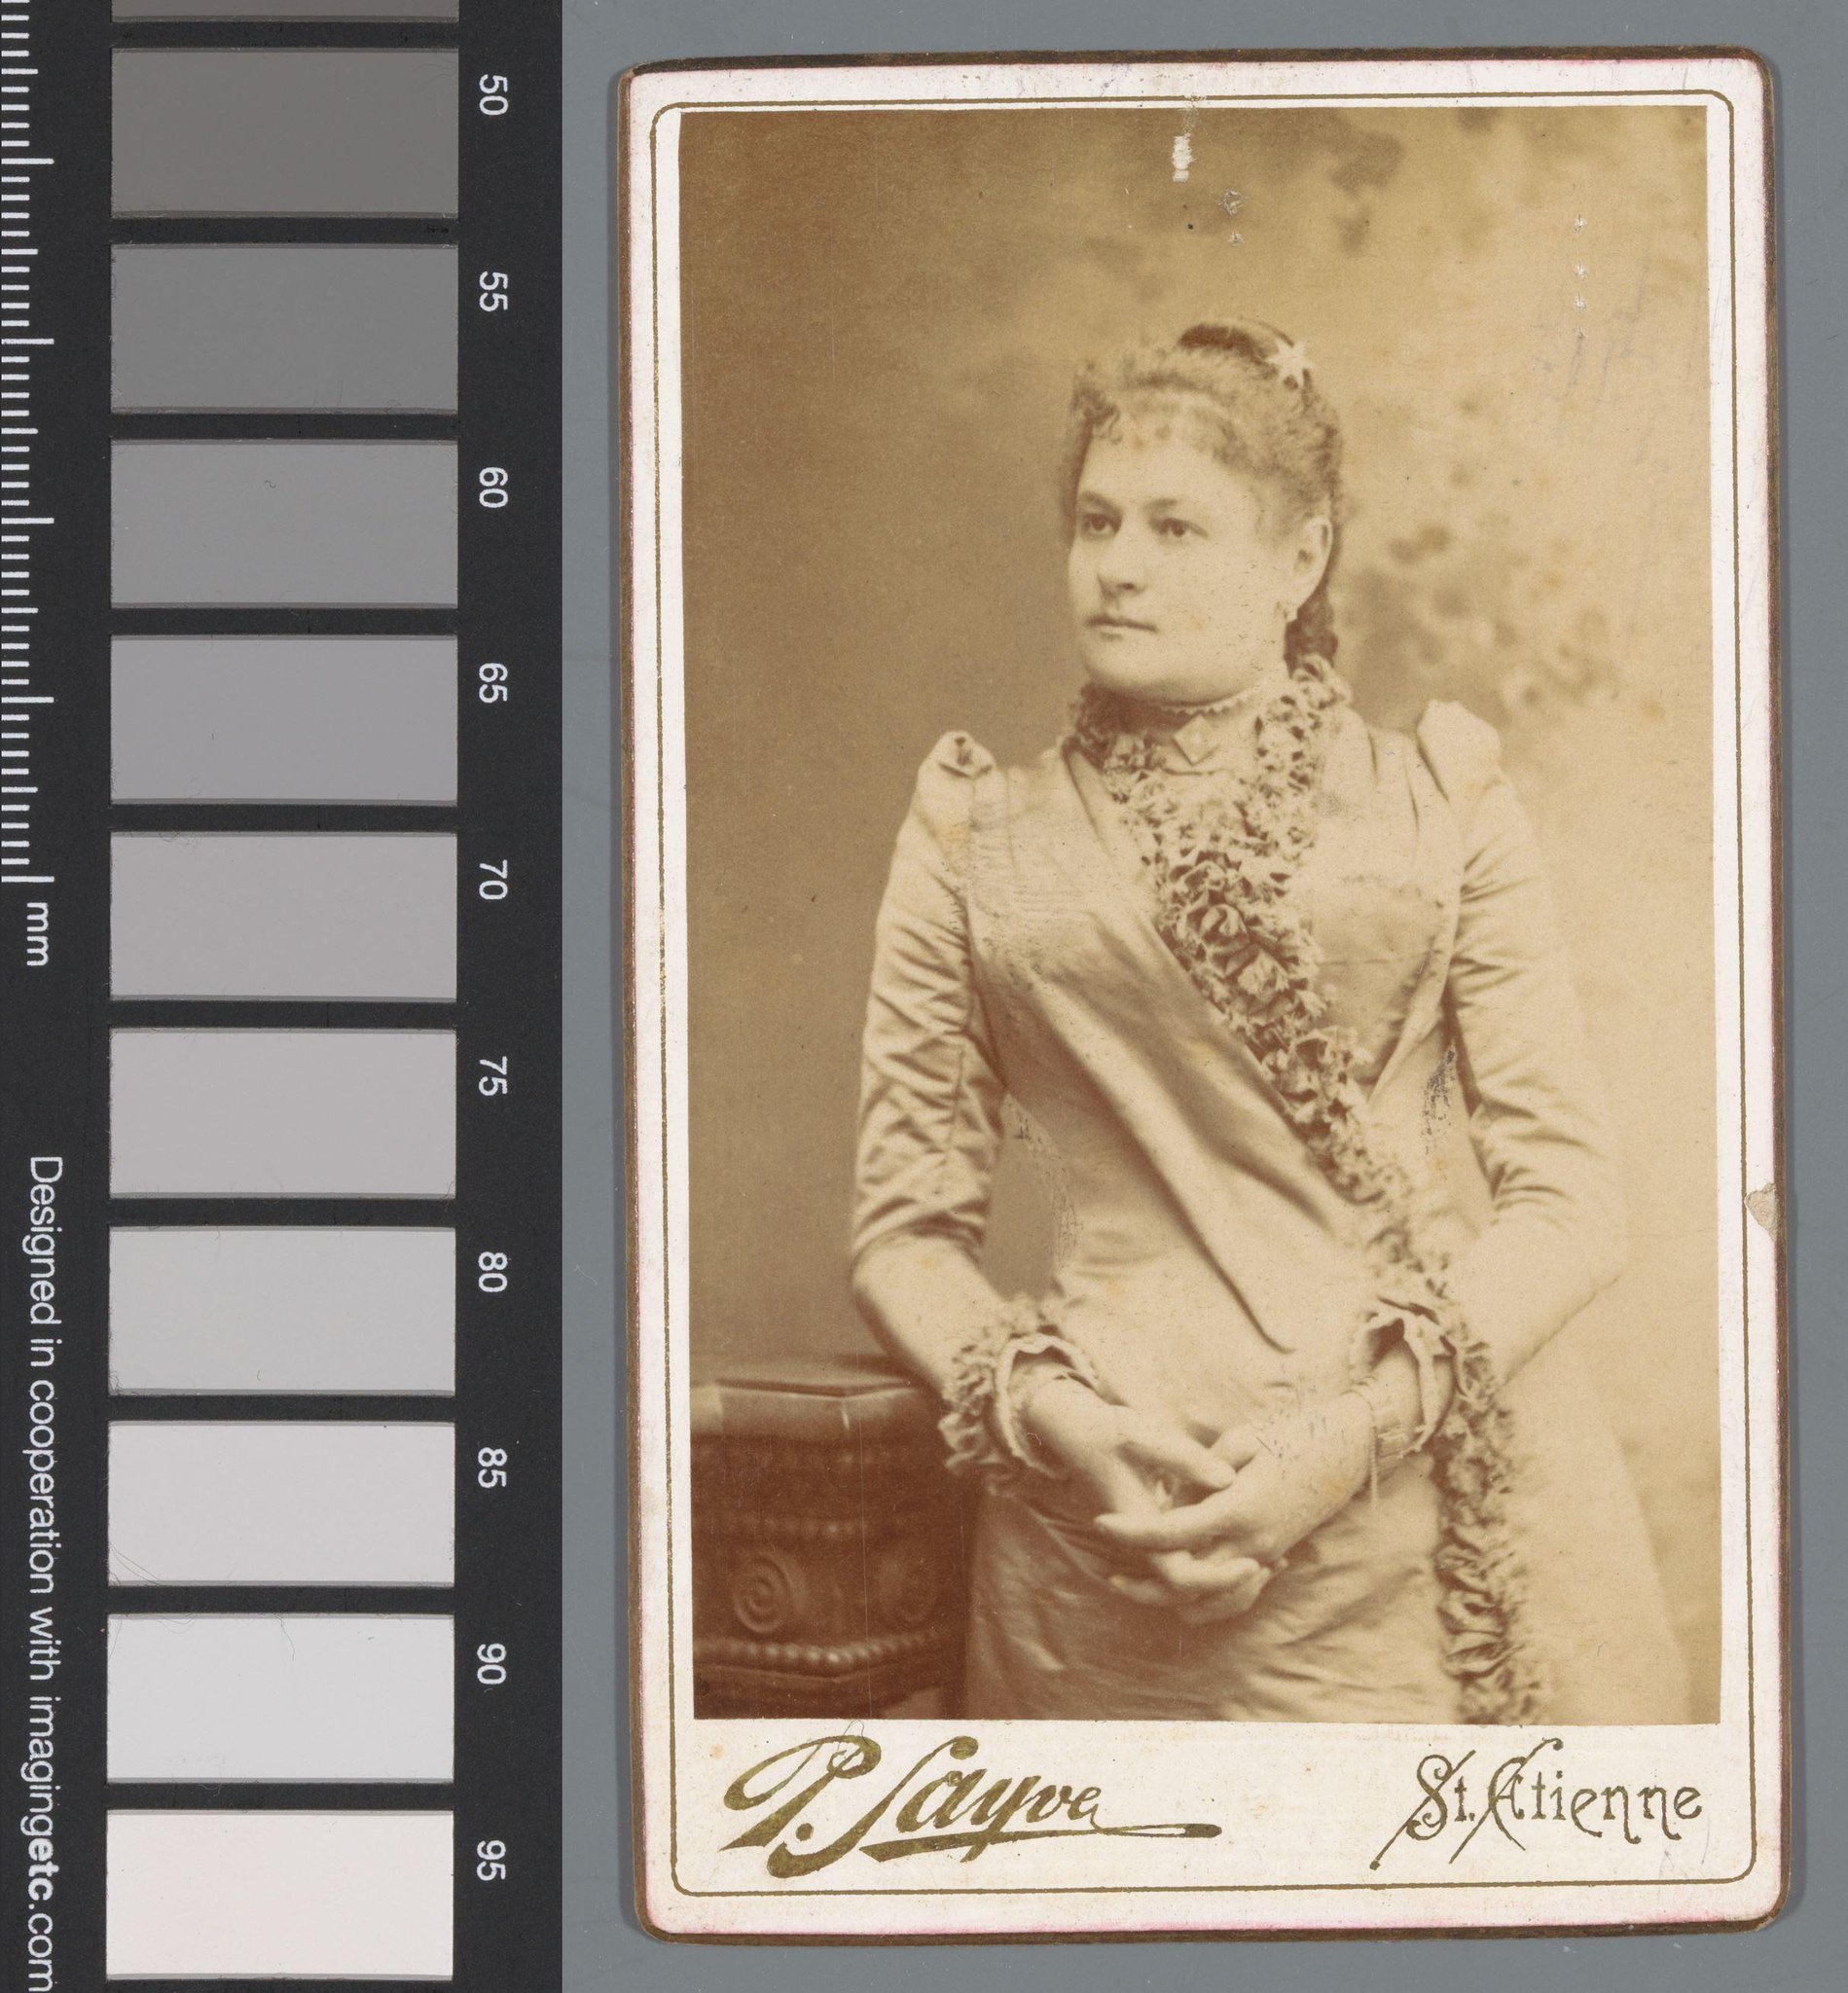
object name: carte de visite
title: Portret van een onbekende vrouw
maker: pierre sayve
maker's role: fotograaf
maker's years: 1849-1897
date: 1890-1895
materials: cardboard, paper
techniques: albumen print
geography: saint-étienne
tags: adult woman, anonymous historical person portrayed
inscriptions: inscription: ‘P. Sayve St. Etienne’, inscription: ‘Agrandissement au Charbon/ Photographie/ P. Sayve/ Place Dorian 10./ St. Etienne/ Tous les clichés sont conservés./ Bernhard Wachtl Wien.’